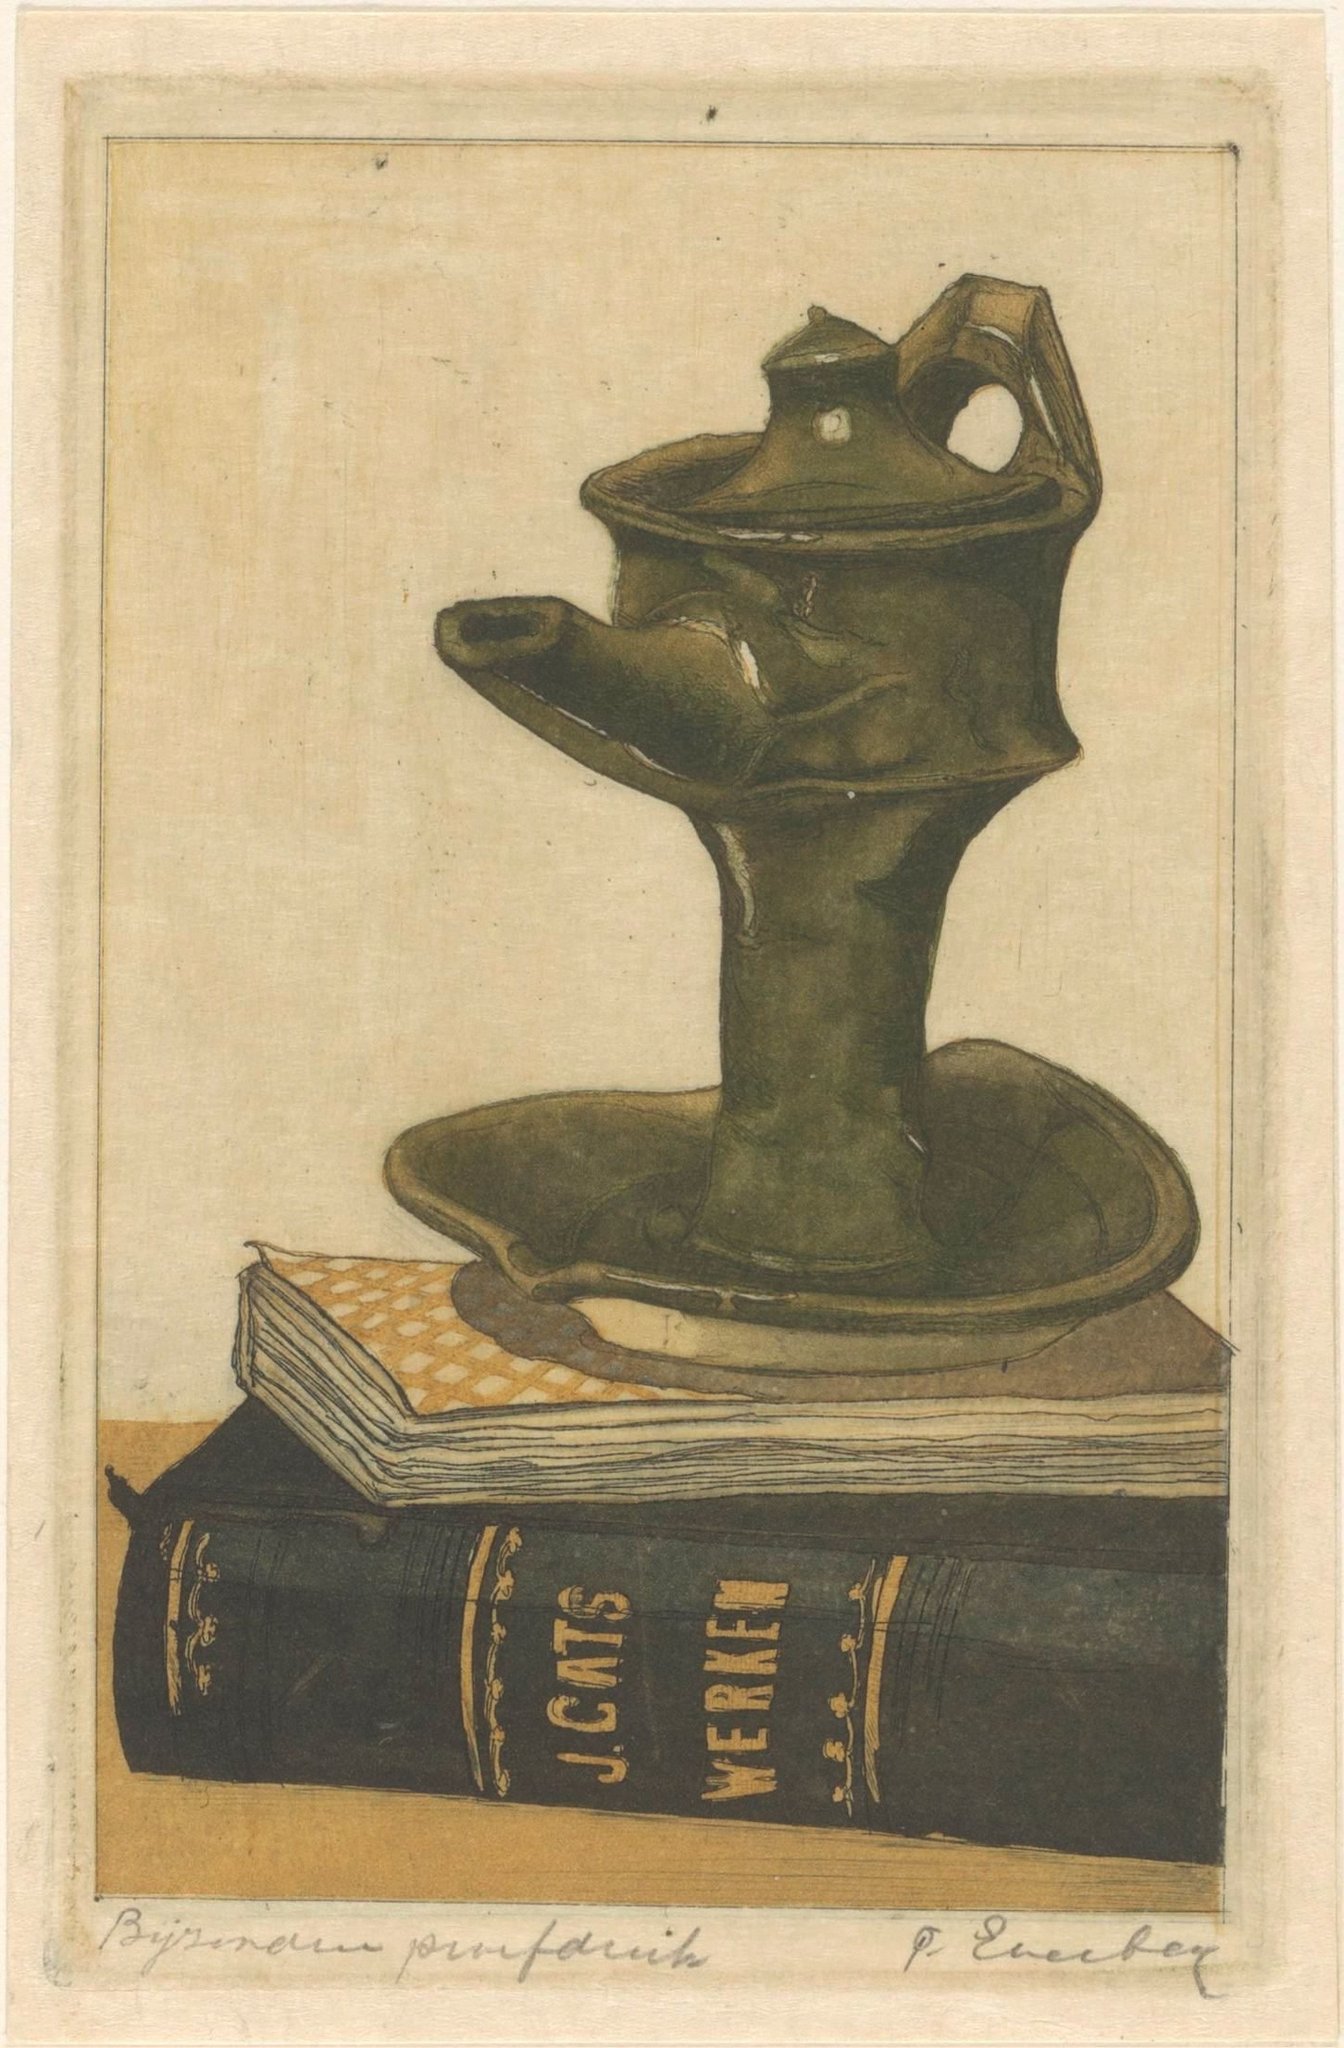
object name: print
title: Stilleven met schenkkan en boeken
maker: frans everbag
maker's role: draughtsman, print maker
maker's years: 1877-1947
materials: paper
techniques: aquatint, etching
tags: jacob cats (1577-1660), book, container of ceramics: jar, jug, pot, vase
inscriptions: collector's mark: Lugt 2228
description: Op het onderste boek het opschrift 'J. Cats, Werken', het verzameld werk van dichter, jurist en politicus Jacob Cats.